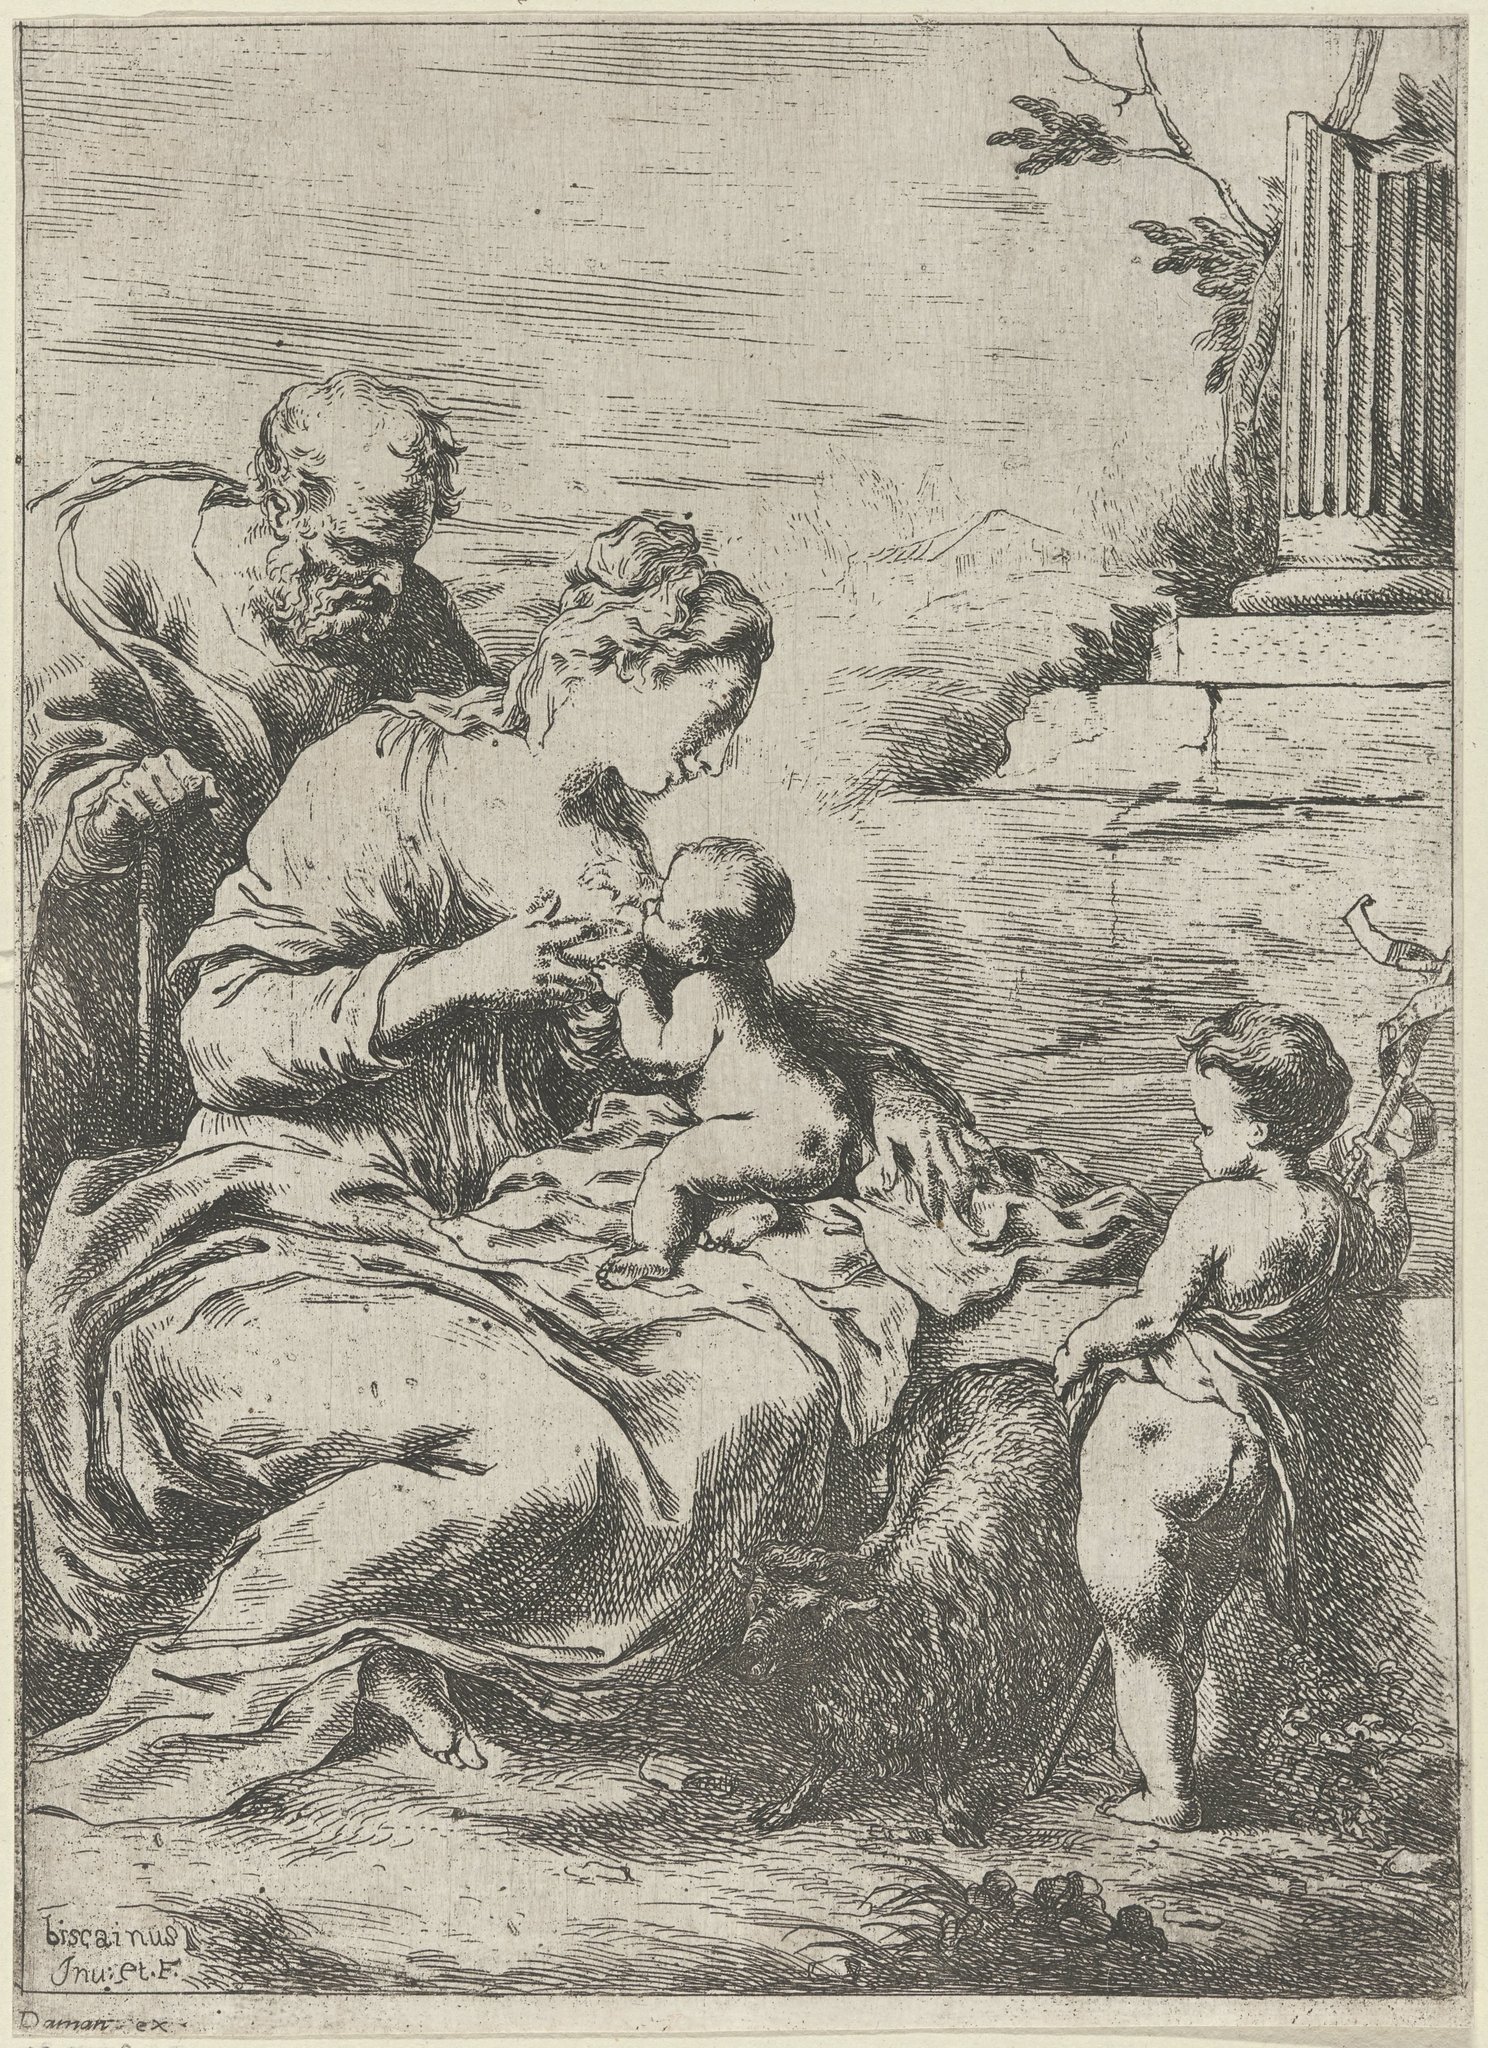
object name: print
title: Maria zoogt het Christuskind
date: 1642-1657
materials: paper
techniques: etching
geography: italy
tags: holy family with john the baptist (as child), christ-child suckling, or beginning to suckle, e.g. mary uncovering her breast ~ madonna-representations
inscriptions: collector's mark: Lugt 240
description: De Heilige Familie met de jonge Johannes de Doper in een landschap met een ruïne van een tempel en op de achtergrond een boerderij. Maria zoogt het Christuskind.